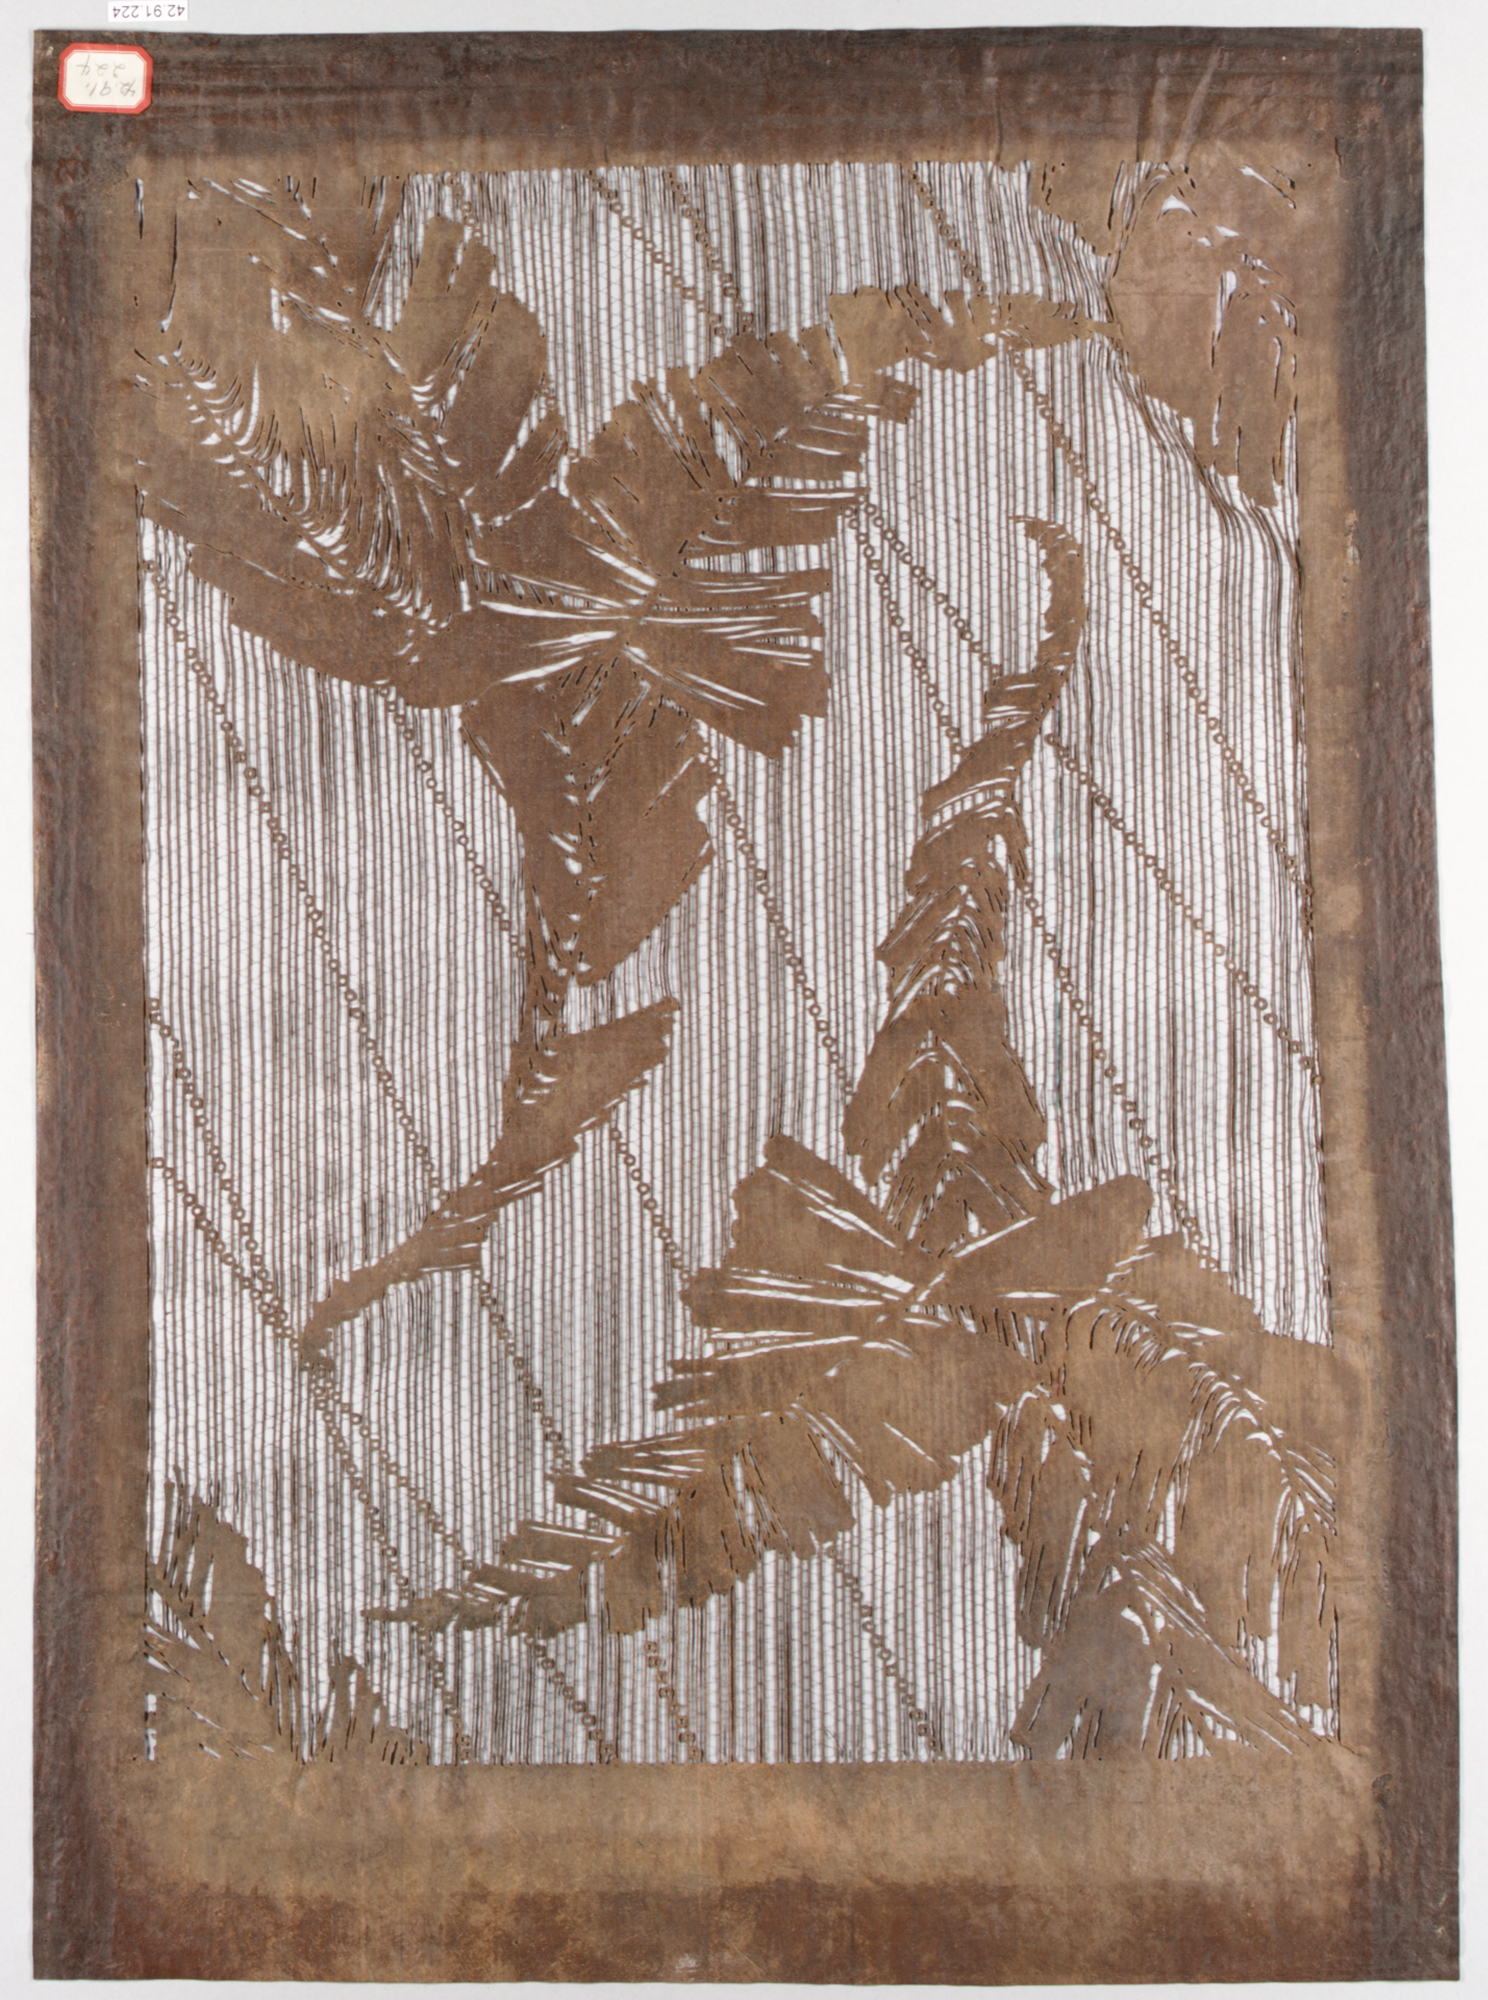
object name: stencil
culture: japanese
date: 1801-1900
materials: paper, silk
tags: leaves